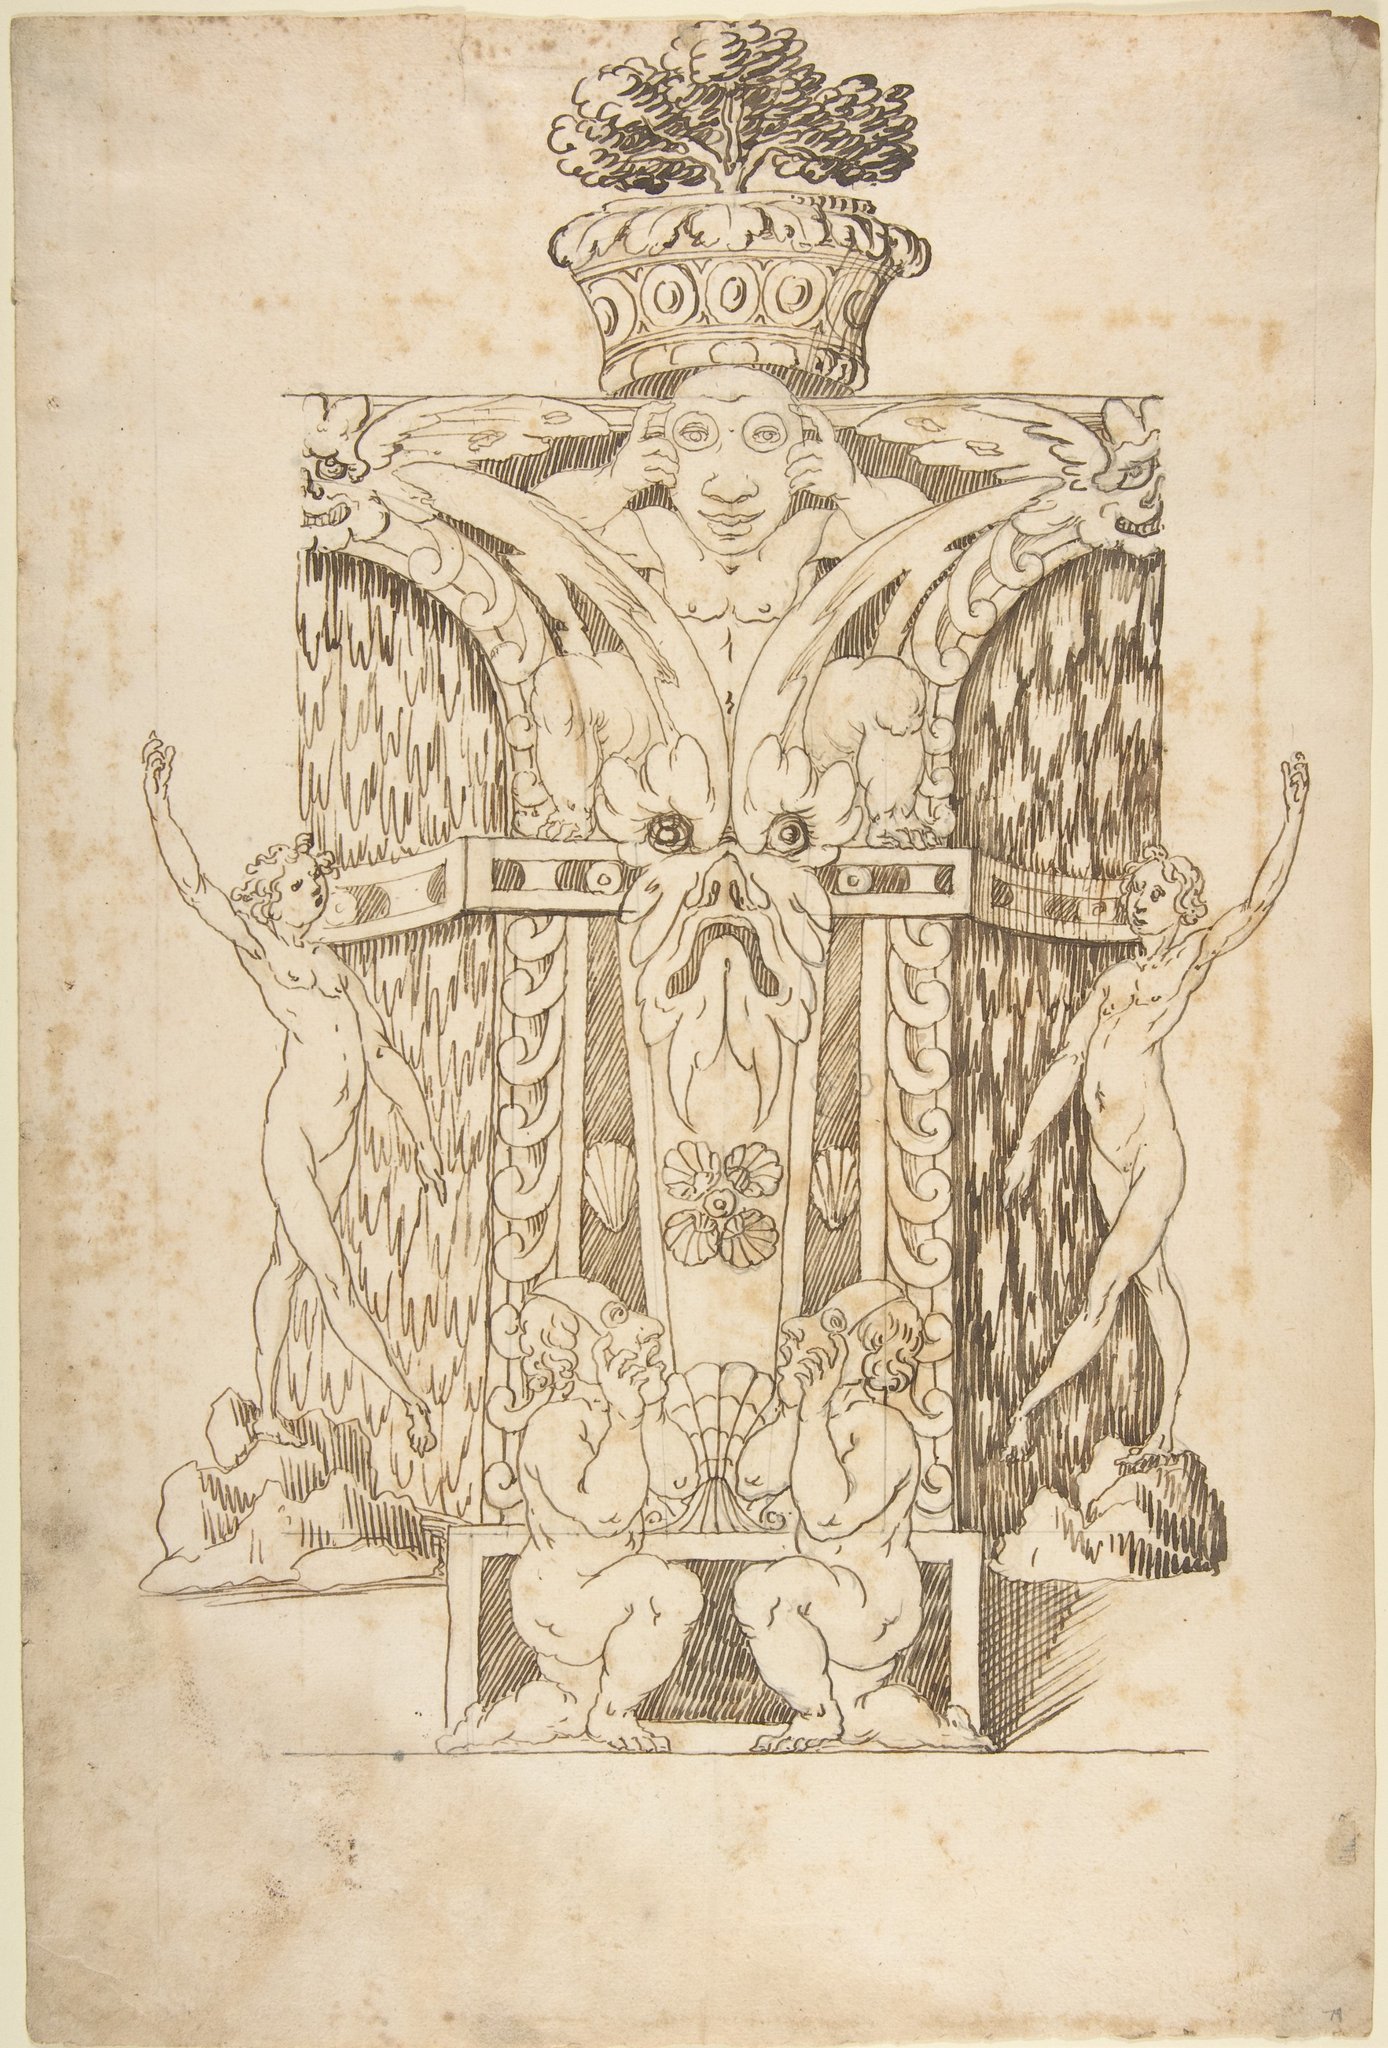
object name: drawing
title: Design for a Wall Fountain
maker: anonymous, italian, lombard, 16th century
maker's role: artist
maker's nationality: italian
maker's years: 1500-1600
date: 1550-1620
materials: graphite, ink, drawing material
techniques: pen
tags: fountains,men,female nudes,trees